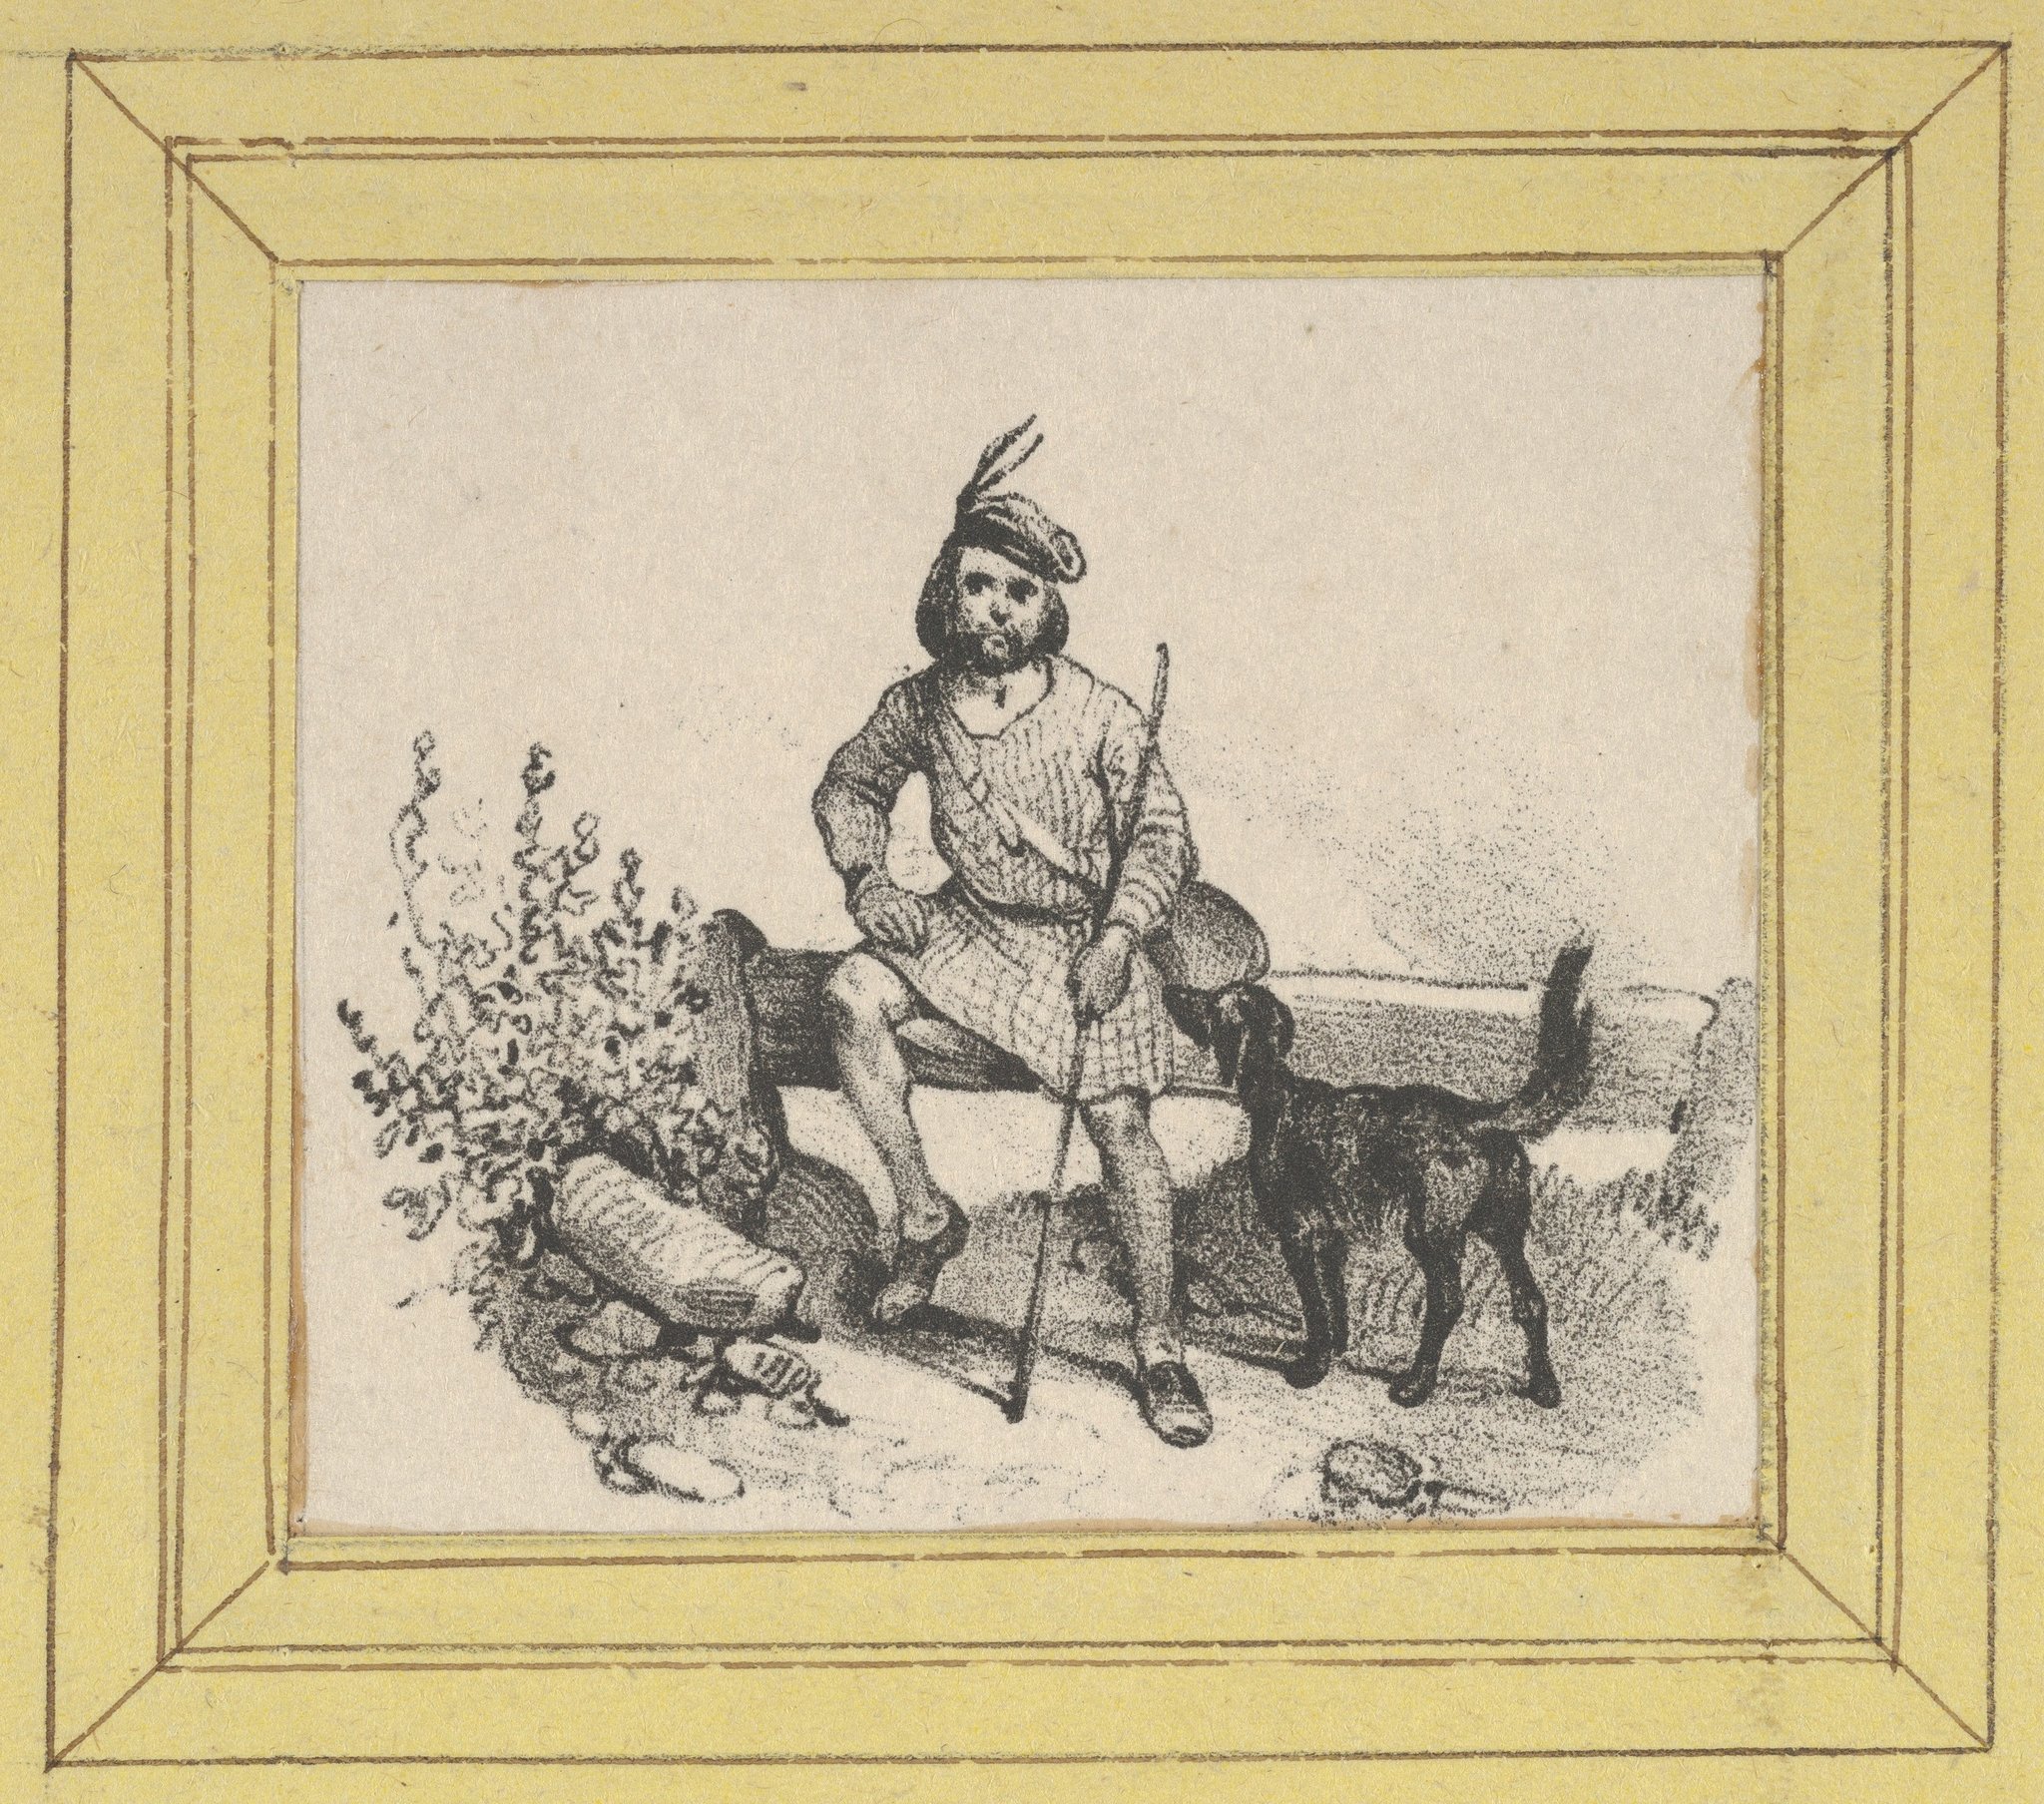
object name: print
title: Man sitting with a dog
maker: victor adam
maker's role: artist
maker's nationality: french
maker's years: 1801-1866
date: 1834-1866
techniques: lithograph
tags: men,portraits,dogs